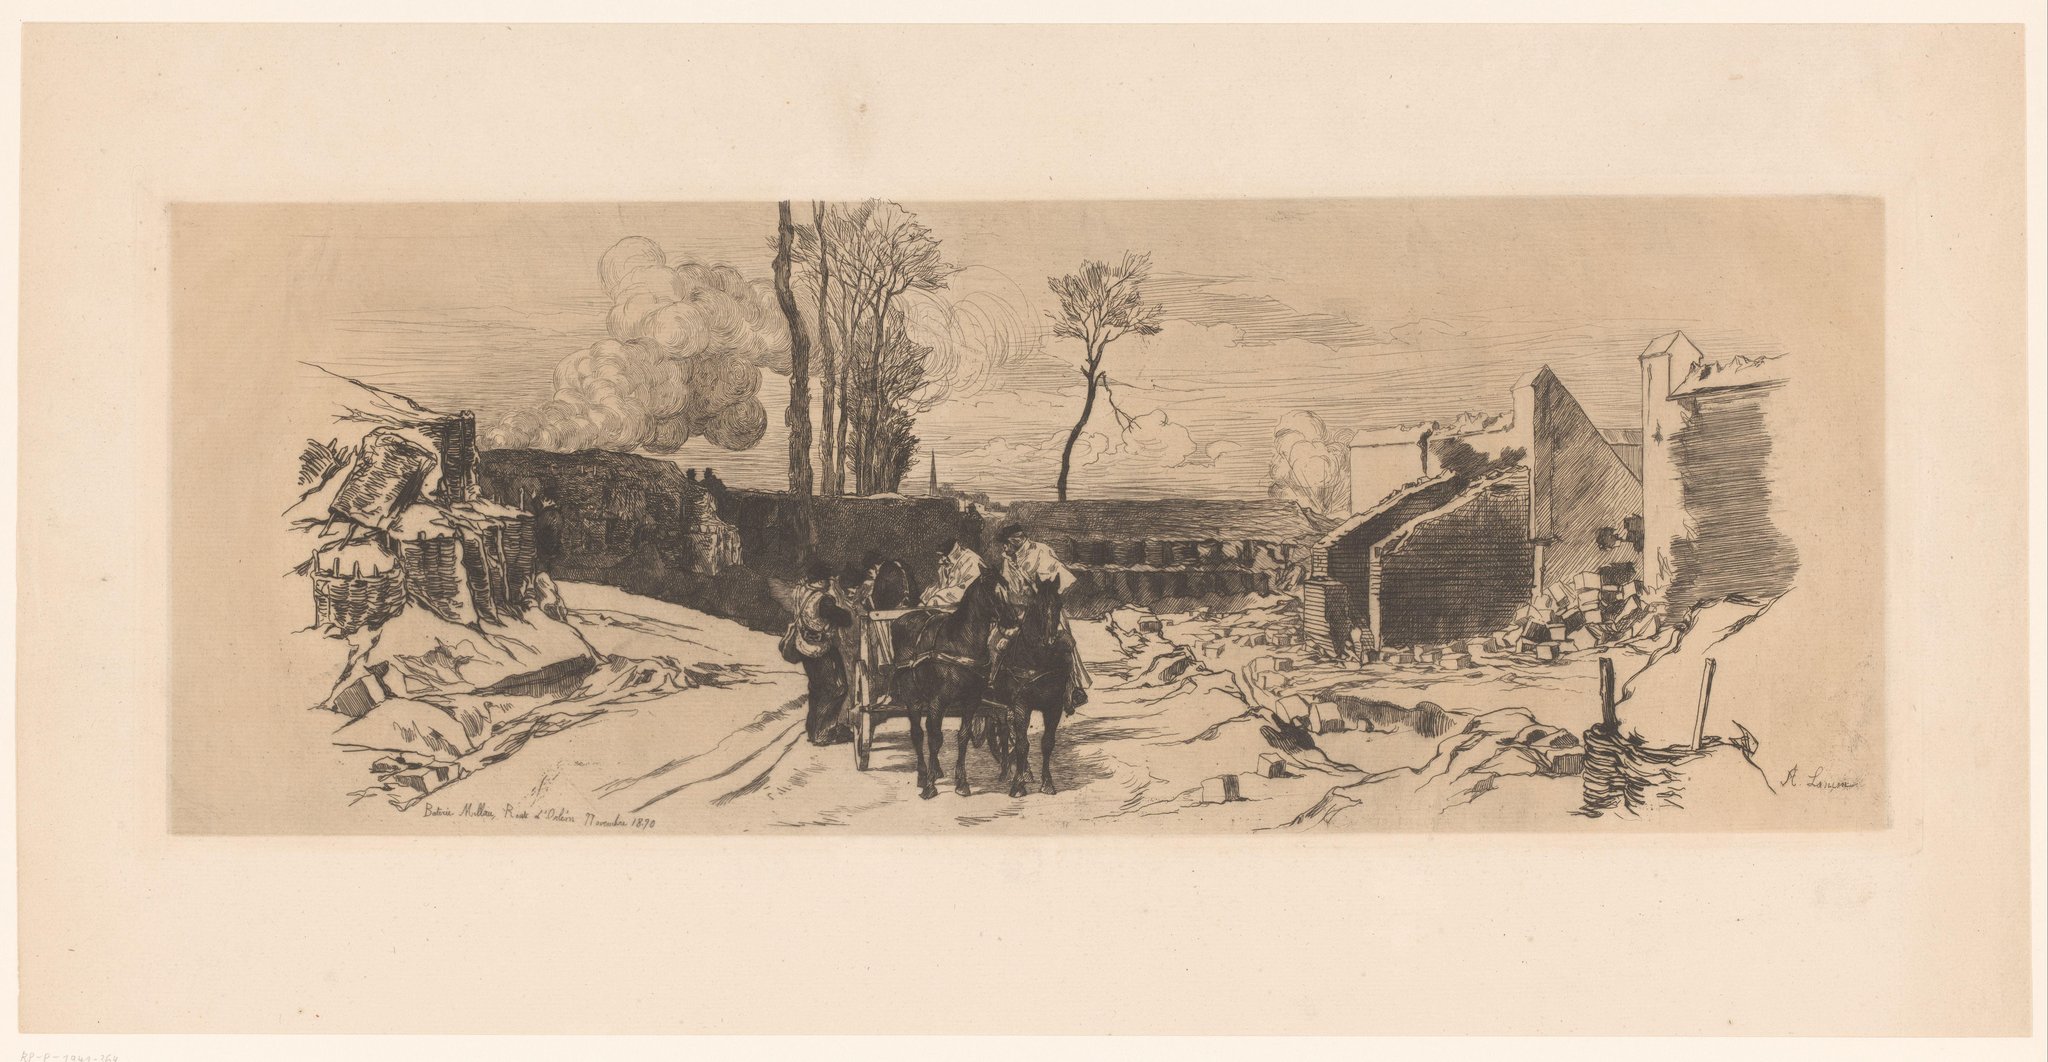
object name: print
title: Baterie Millau, Route d'Orléon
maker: auguste andré lançon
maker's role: print maker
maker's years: 1836-1887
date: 1870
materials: paper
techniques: drypoint, engraving, etching, intaglio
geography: france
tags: the soldier; the soldier's life, war, four-wheeled vehicle drawn by two animals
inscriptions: collector's mark: Lugt 2760, collector's mark: Lugt 2228, watermark